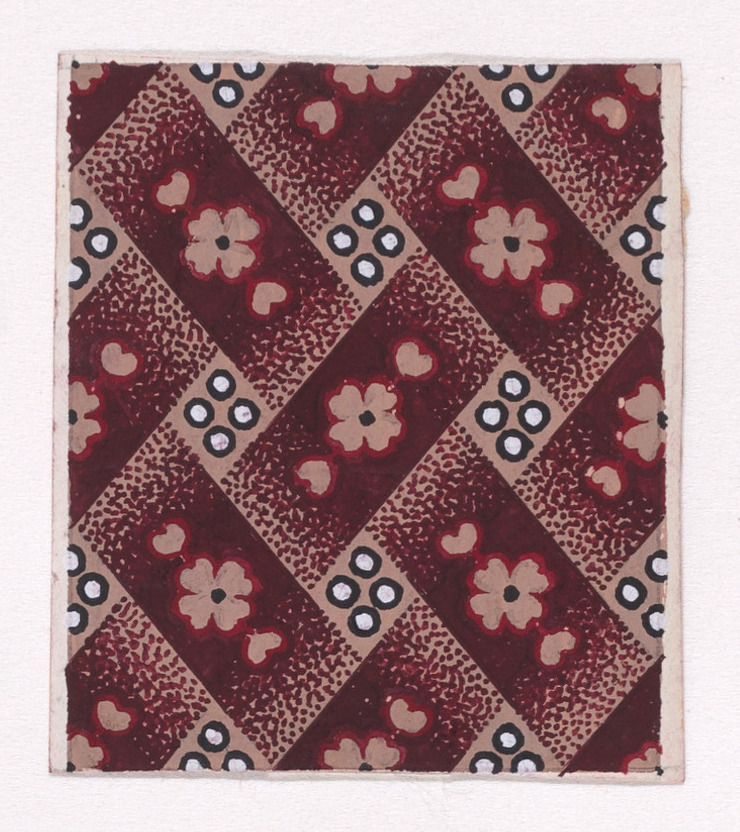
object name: drawing ornament architecture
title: Textile Design with Basketweave Pattern Background, Small Rosettes Flanked by Two Leaves and Pearls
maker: anonymous, alsatian, 19th century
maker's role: artist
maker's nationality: alsatian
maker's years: 1800-1900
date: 1840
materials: gouache